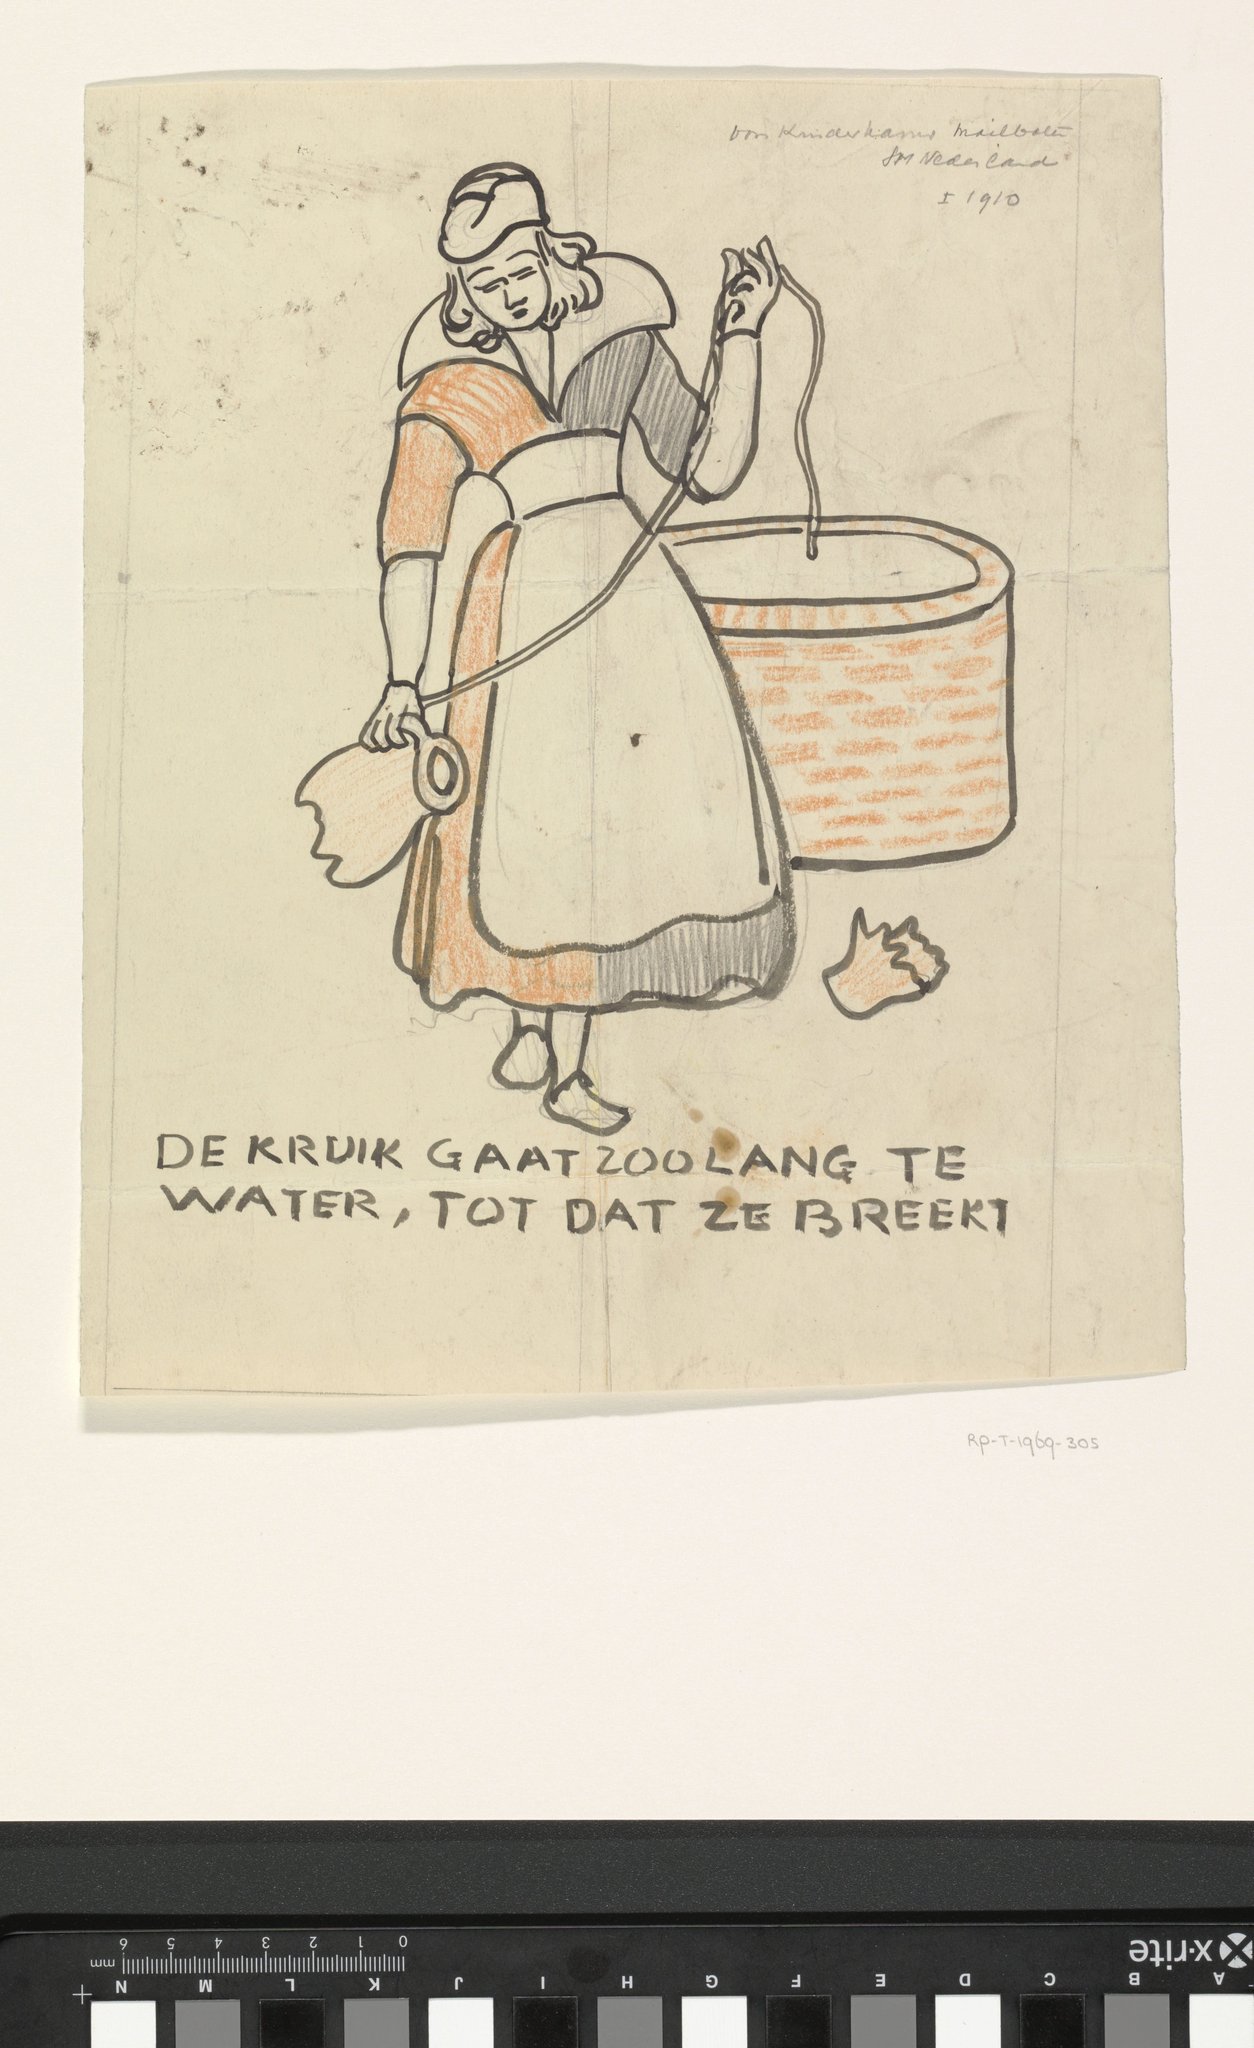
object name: drawing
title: Ontwerp voor een schildering in de kinderkamer van de Mailboot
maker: carel adolph lion cachet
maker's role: draughtsman, print maker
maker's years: 1864-1945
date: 1874-1945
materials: chalk, ink, paper, pencil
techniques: pen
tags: proverbs, sayings, etc.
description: Ontwerp voor een schildering in de kinderkamer van de Mailboot: uitbeelding van het spreekwoord 'De kruik gaat zoo lang te water, tot dat ze breekt'.